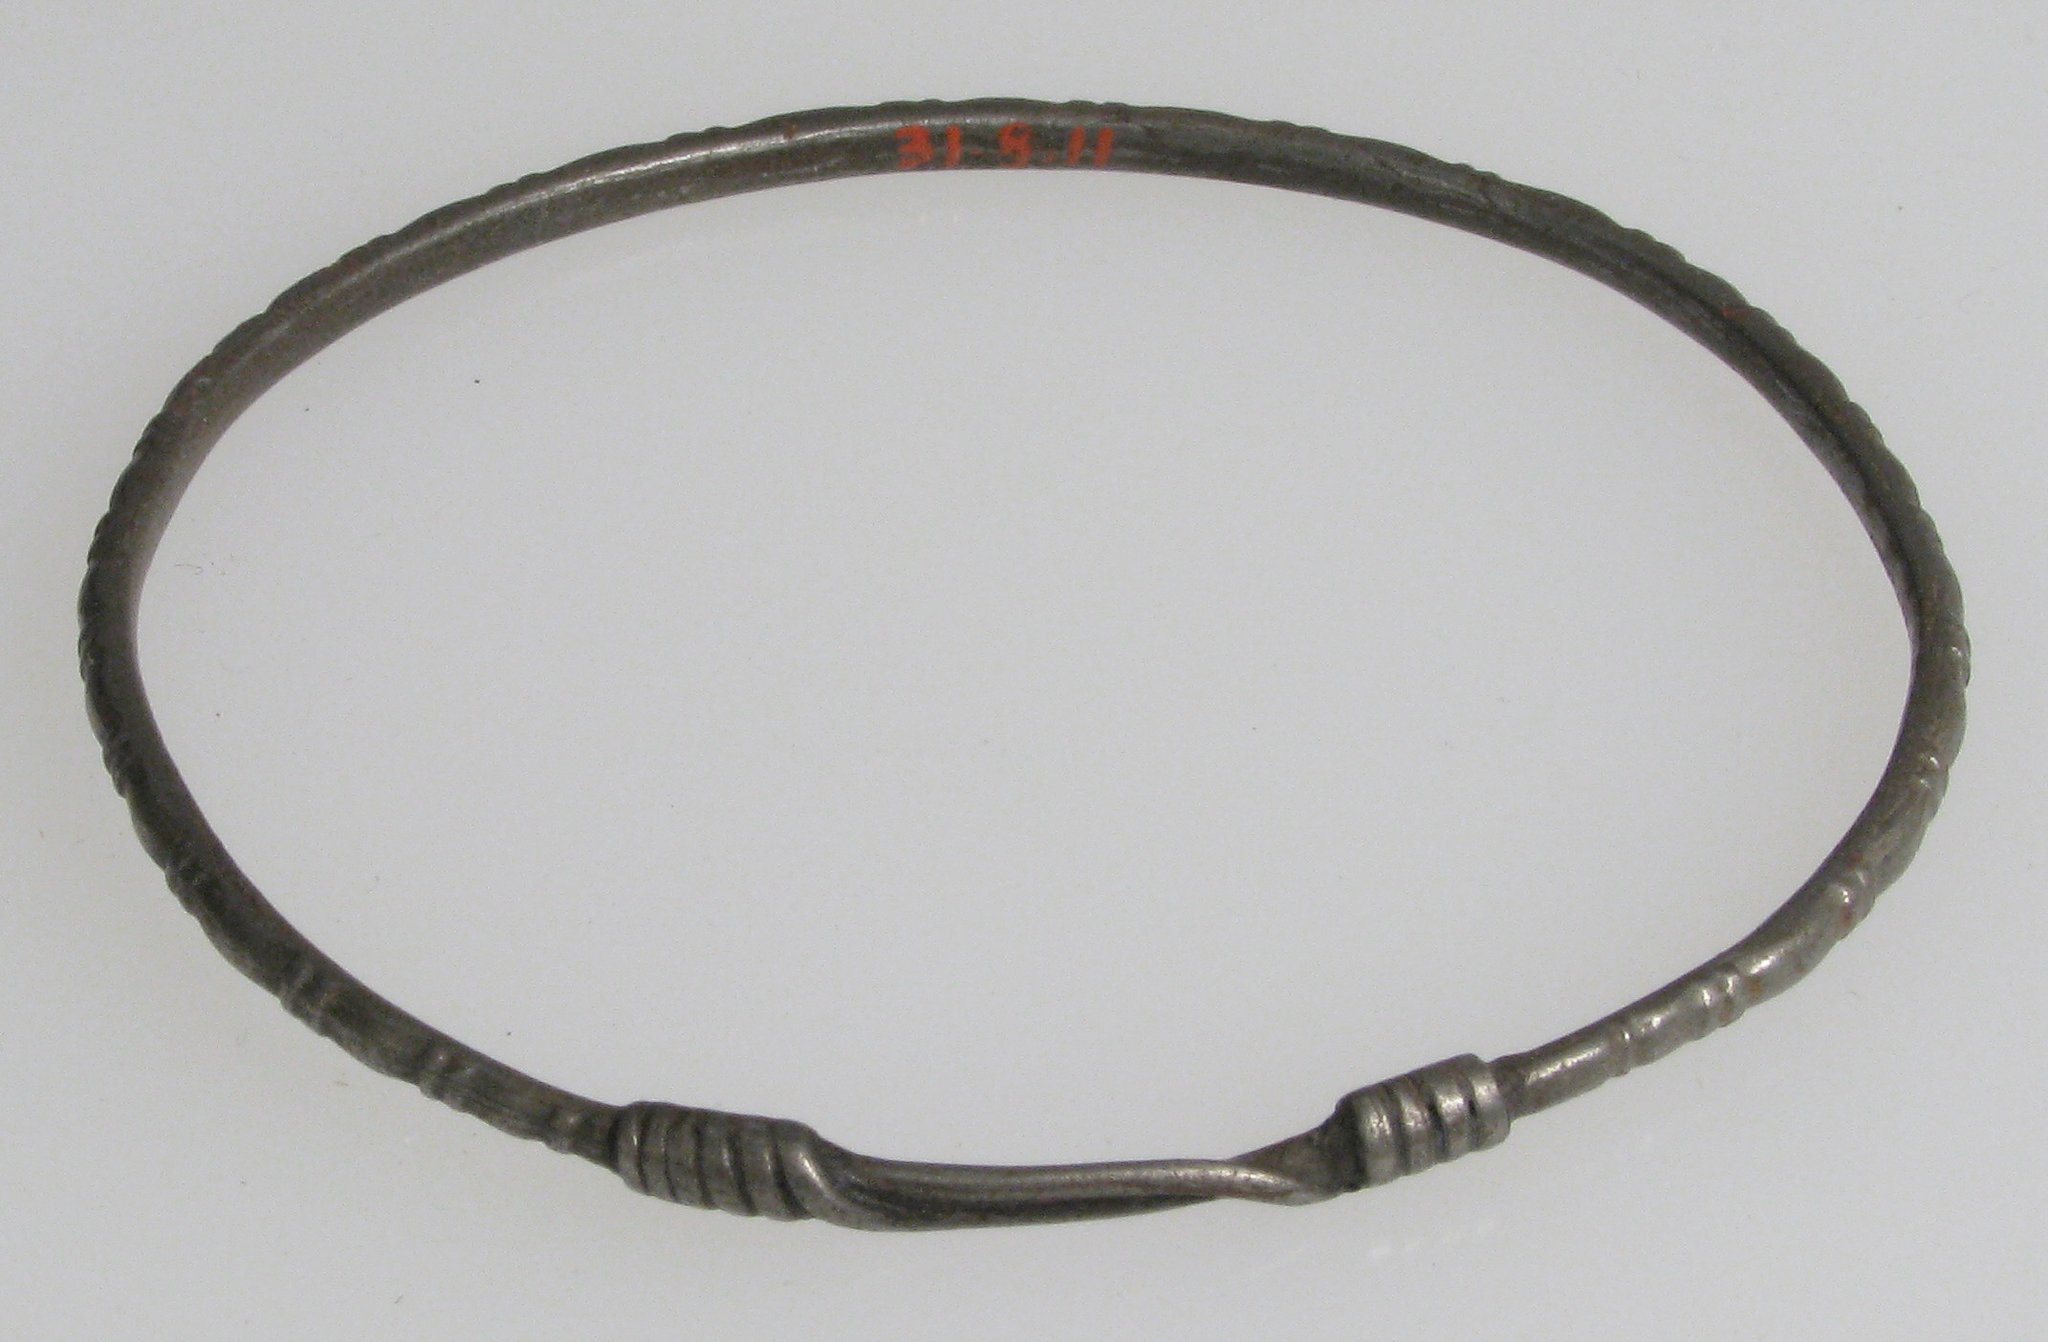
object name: bracelet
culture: coptic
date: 301-700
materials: iron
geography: egypt